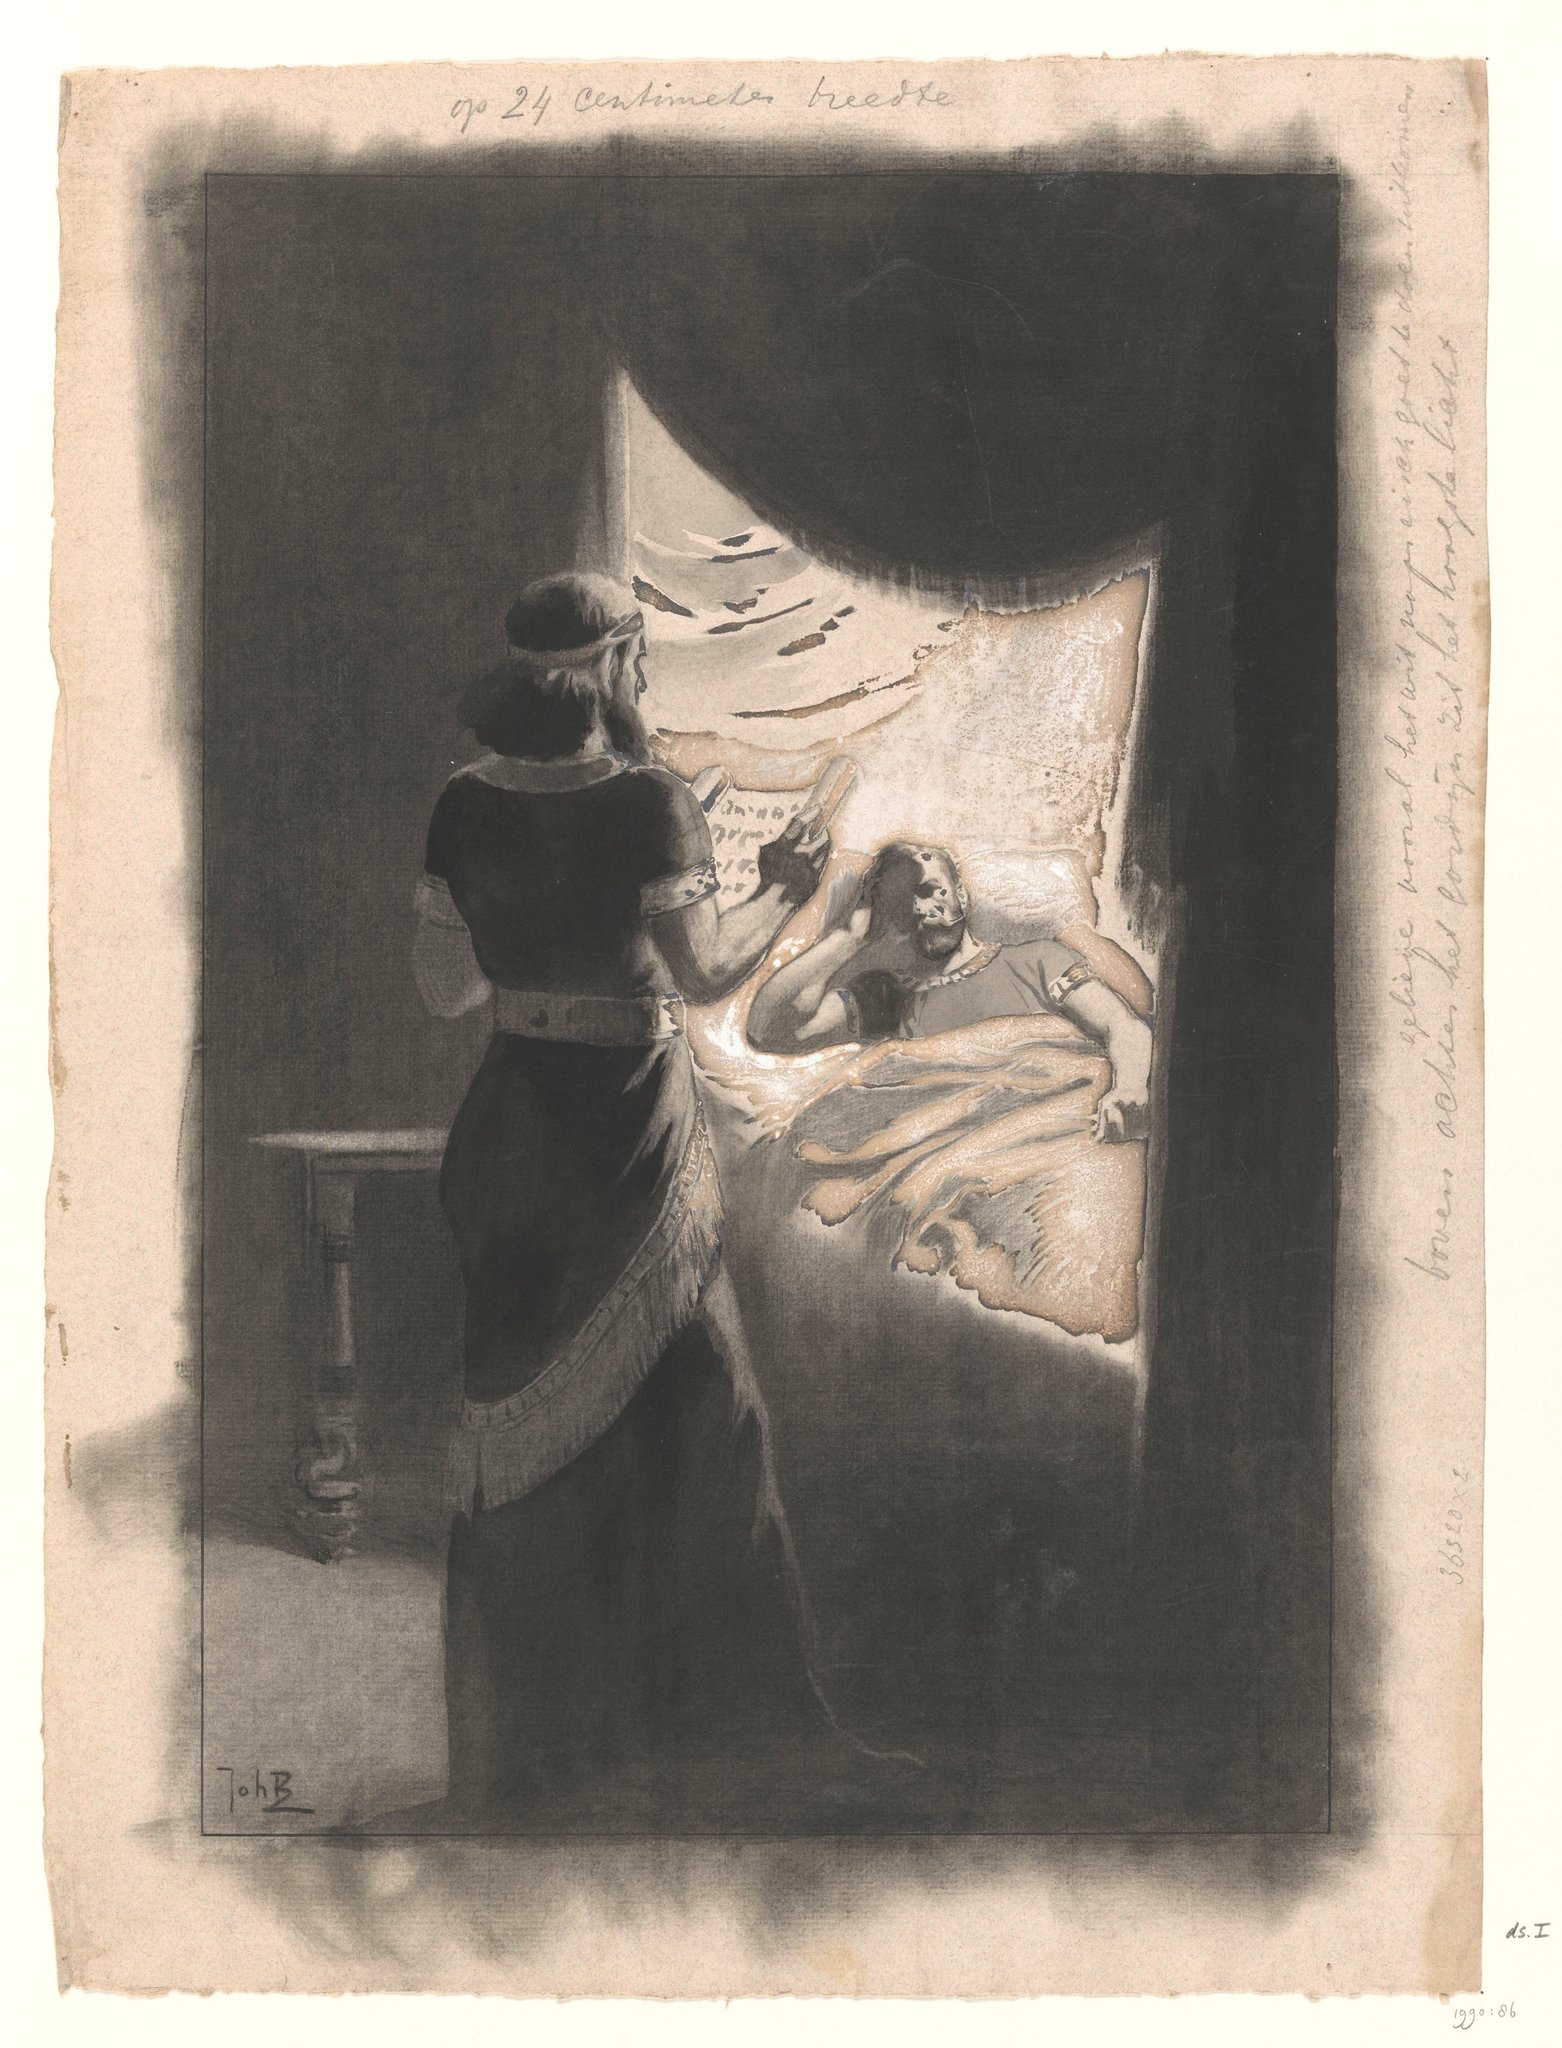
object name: design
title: Ontwerp voor illustratie in De Amsterdammer: Doux pays (...)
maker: johan braakensiek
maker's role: draughtsman, print maker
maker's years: 1858-1940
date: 1911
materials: chalk, paint, paper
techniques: brush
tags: political caricatures and satires